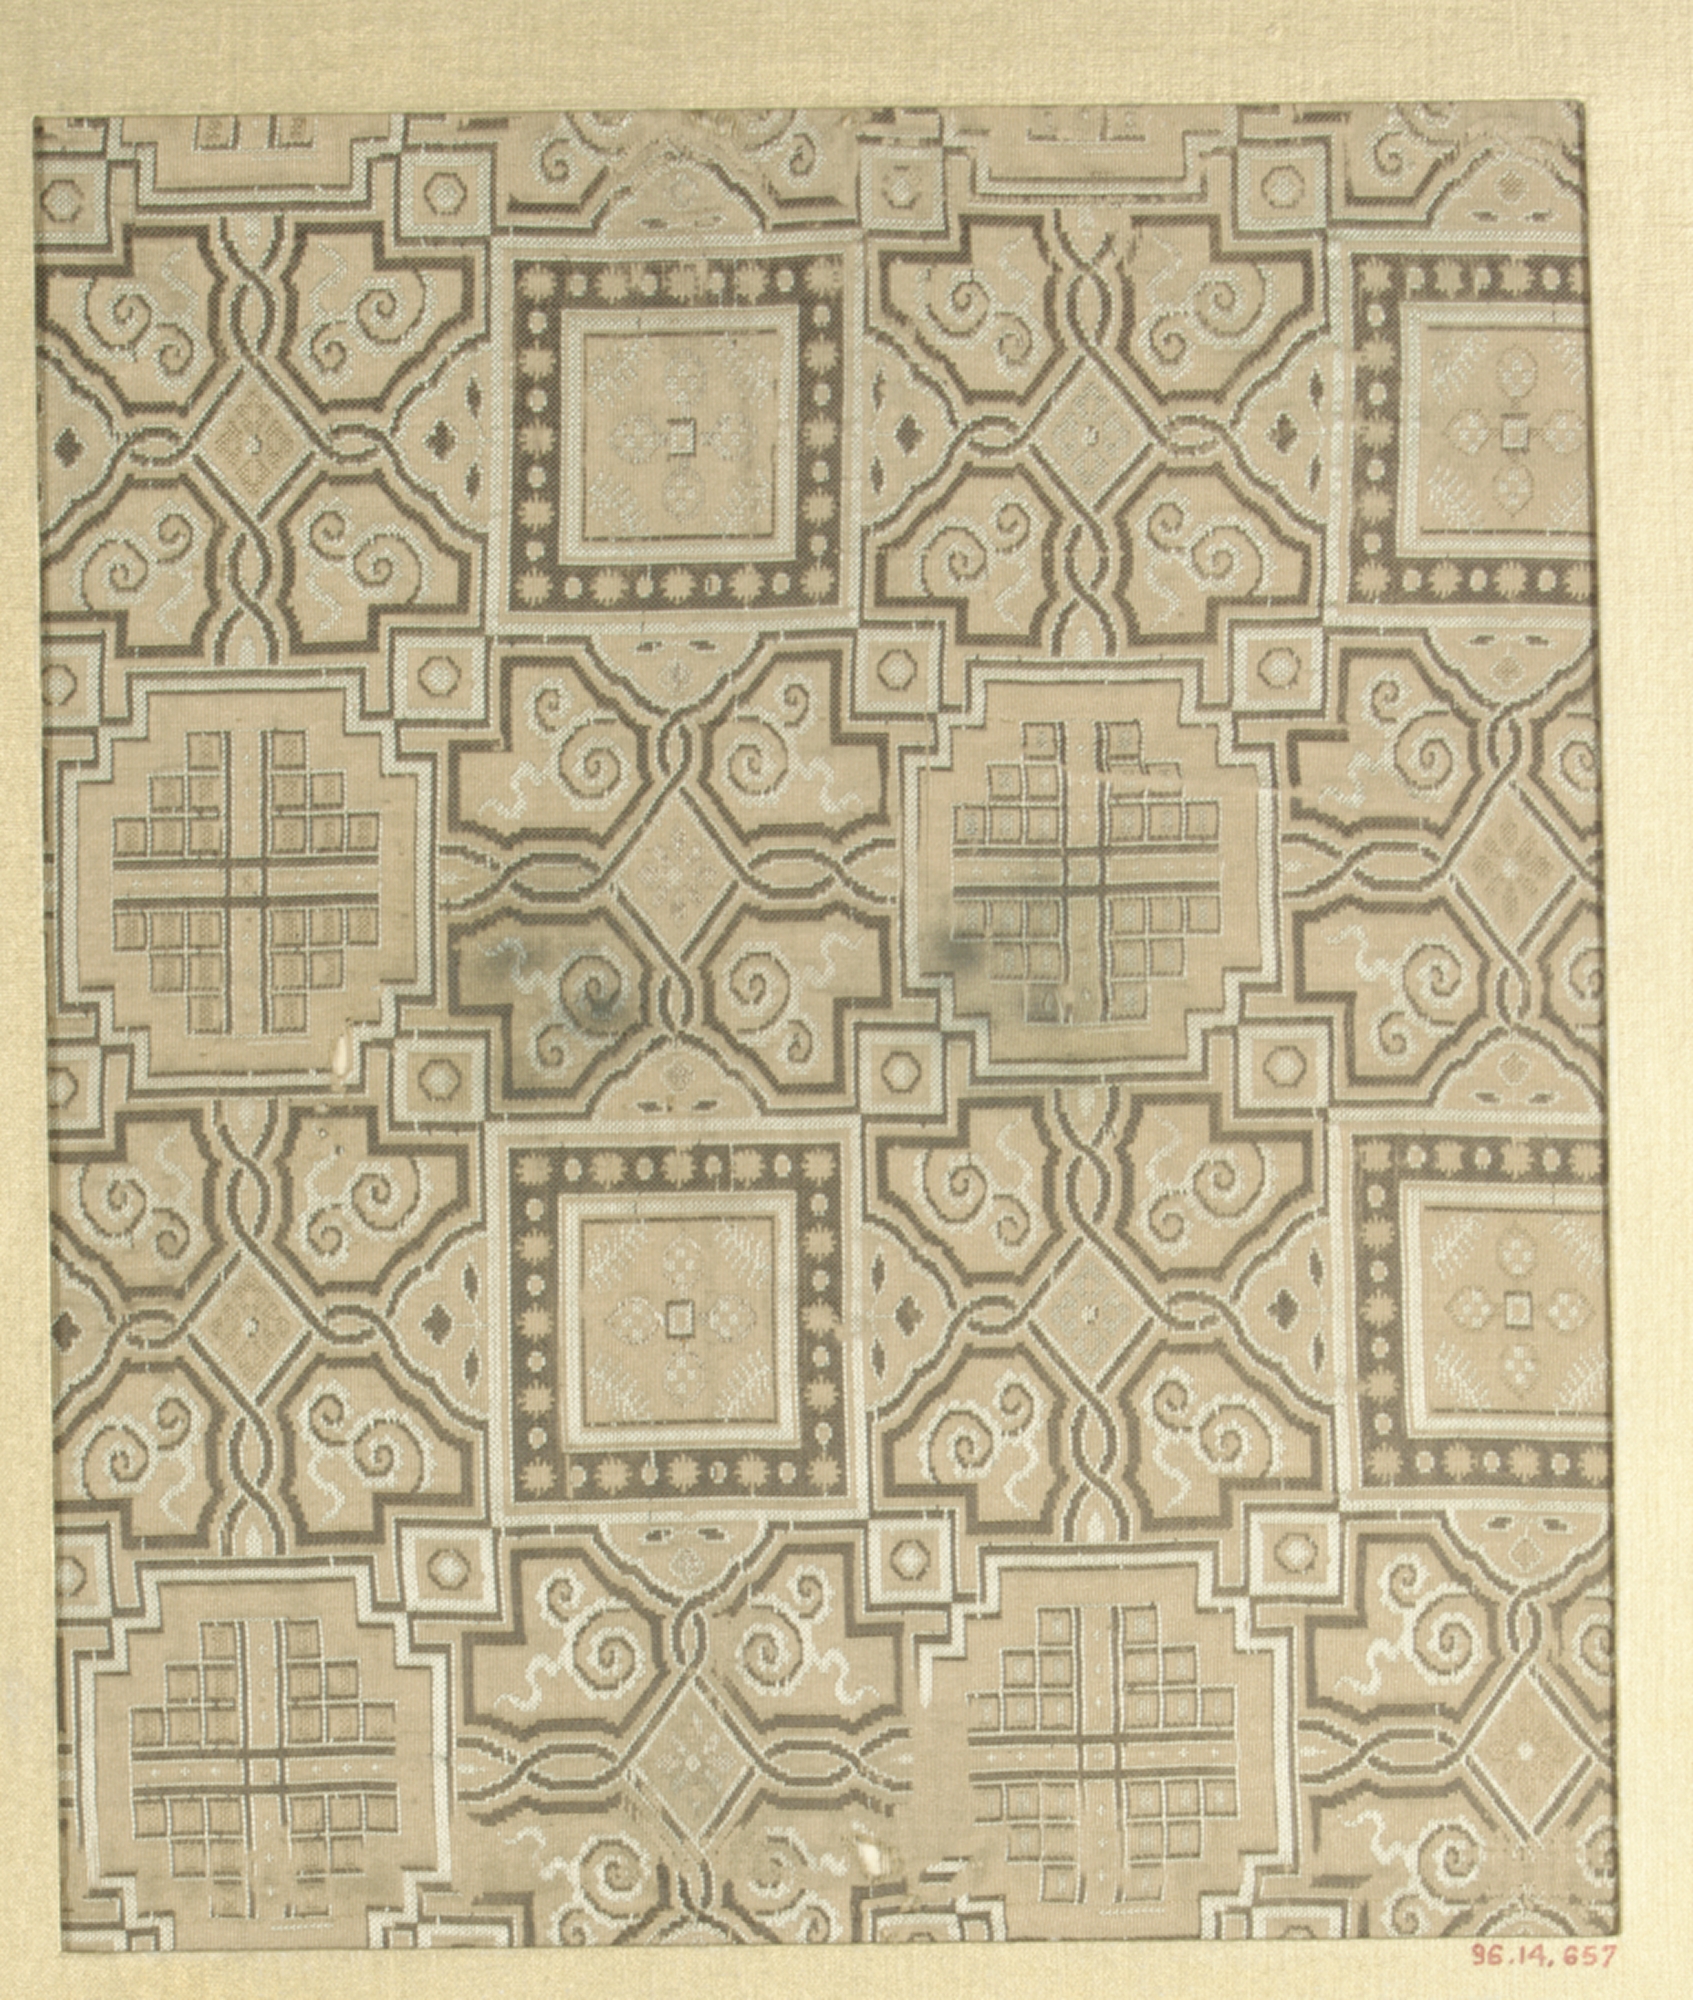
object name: piece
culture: japanese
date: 1701-1900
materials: silk